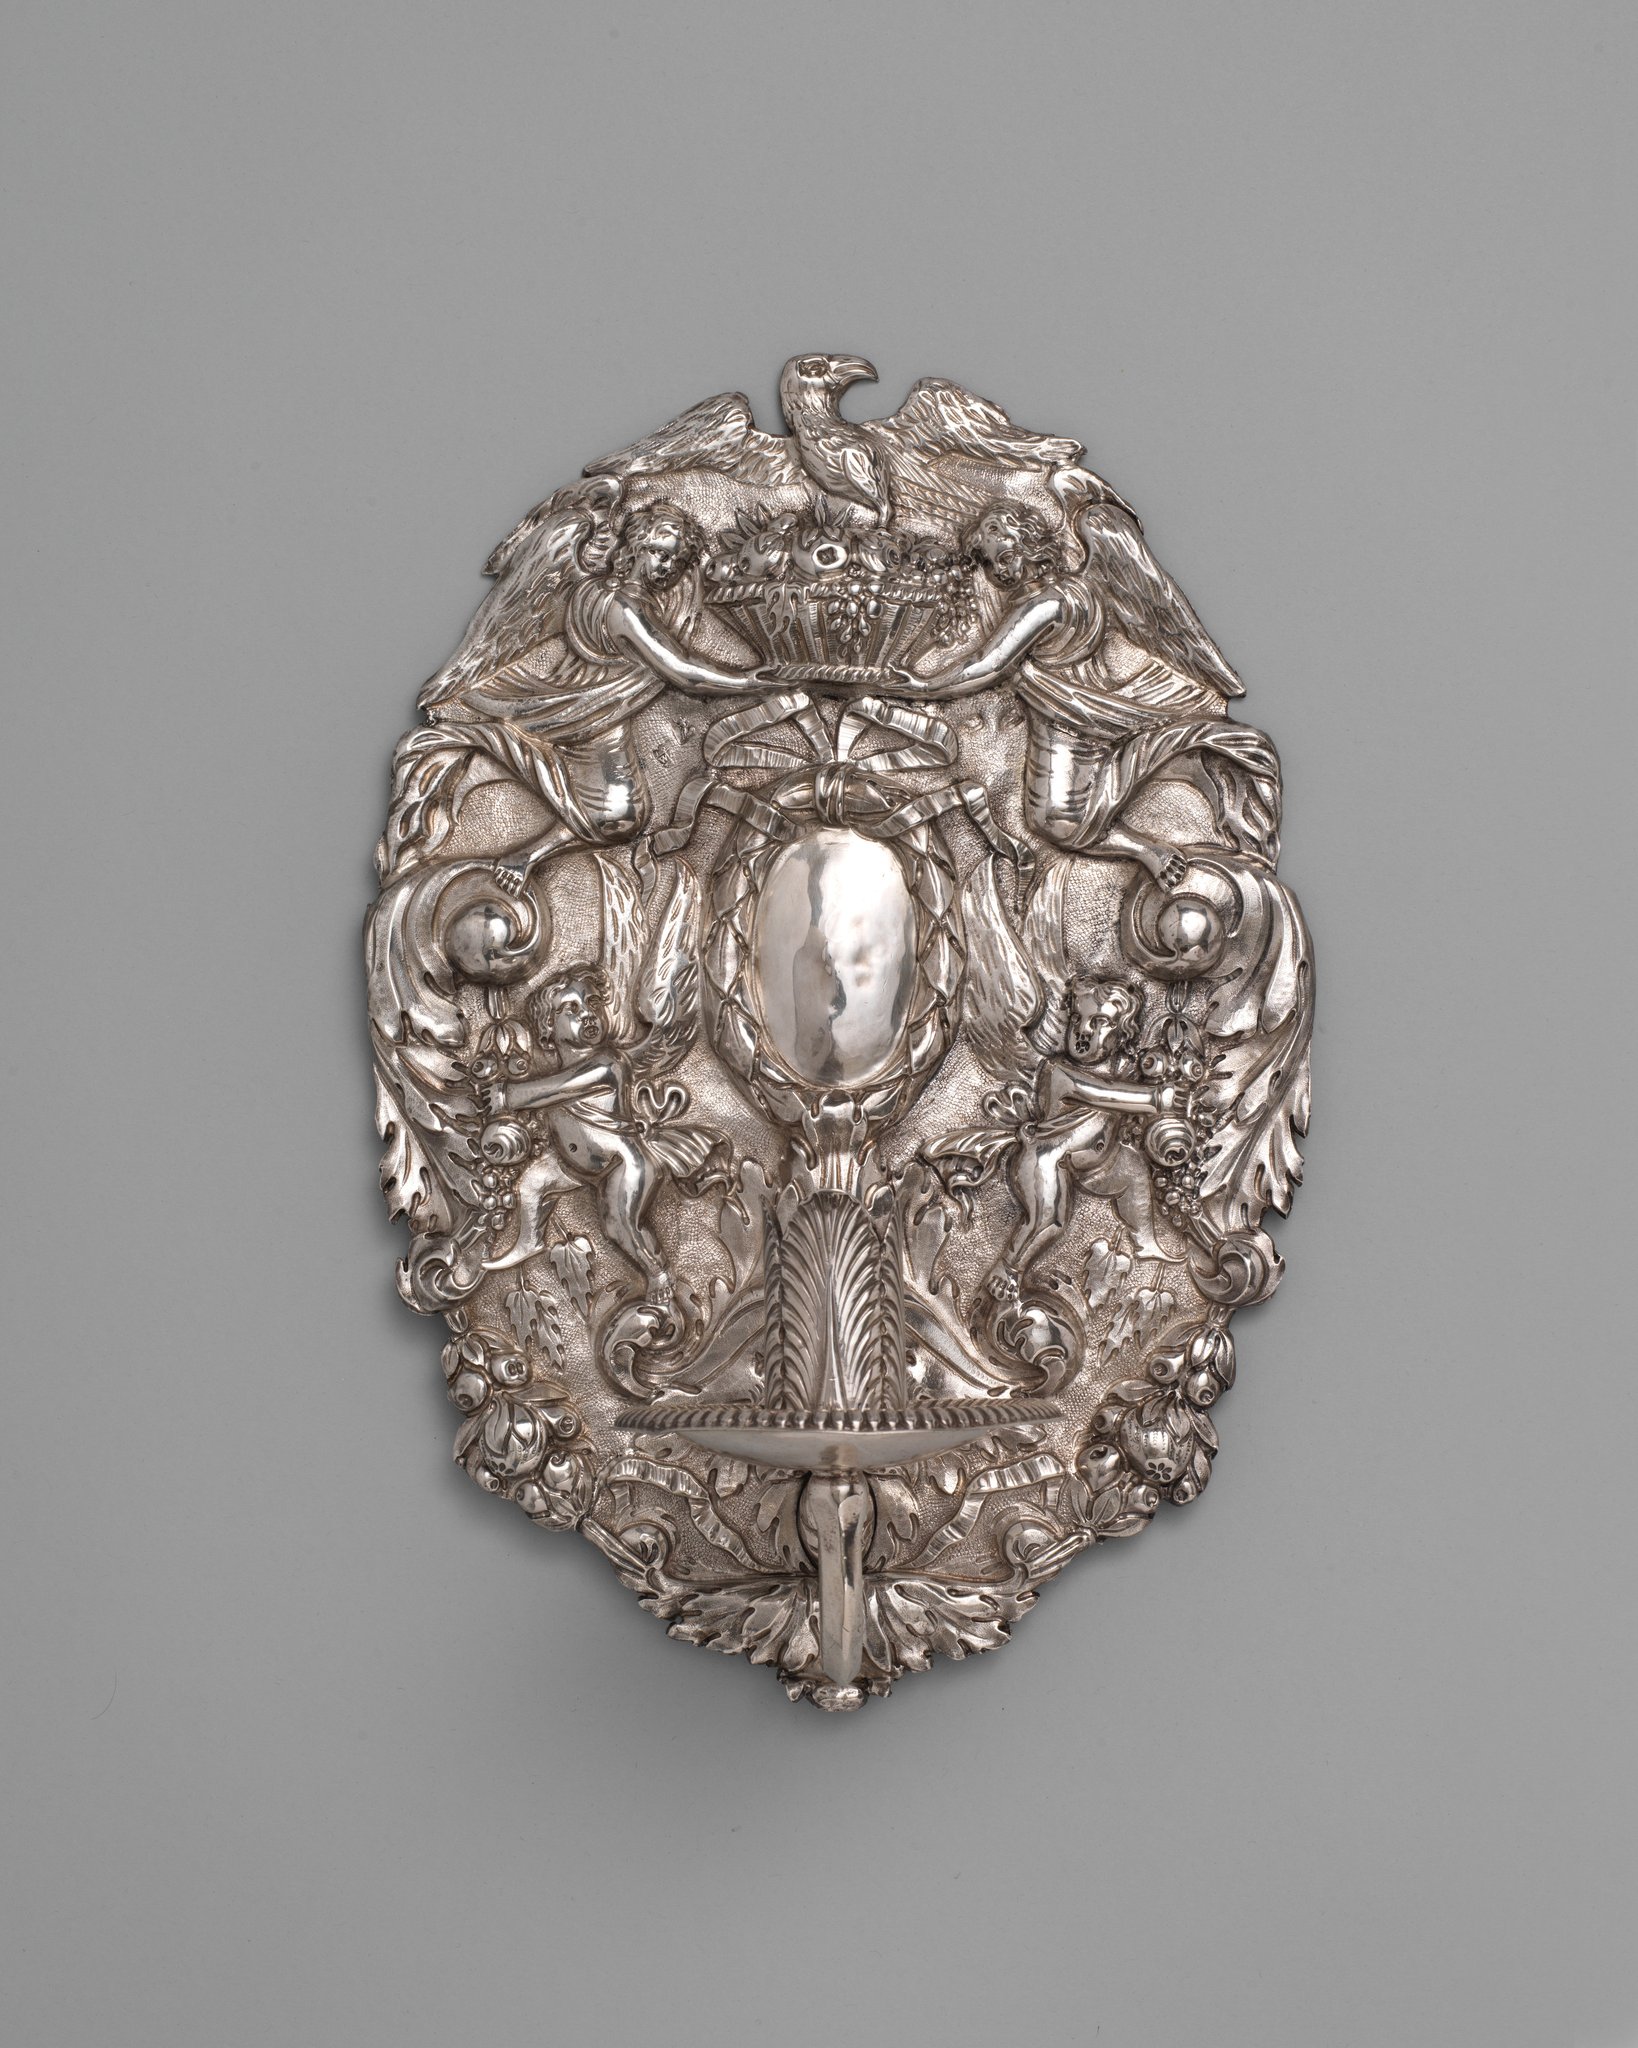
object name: sconce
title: Sconce (one of a pair)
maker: joseph ward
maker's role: maker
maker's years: 1689-1734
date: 1700-1701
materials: silver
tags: eagles,cupid,angels